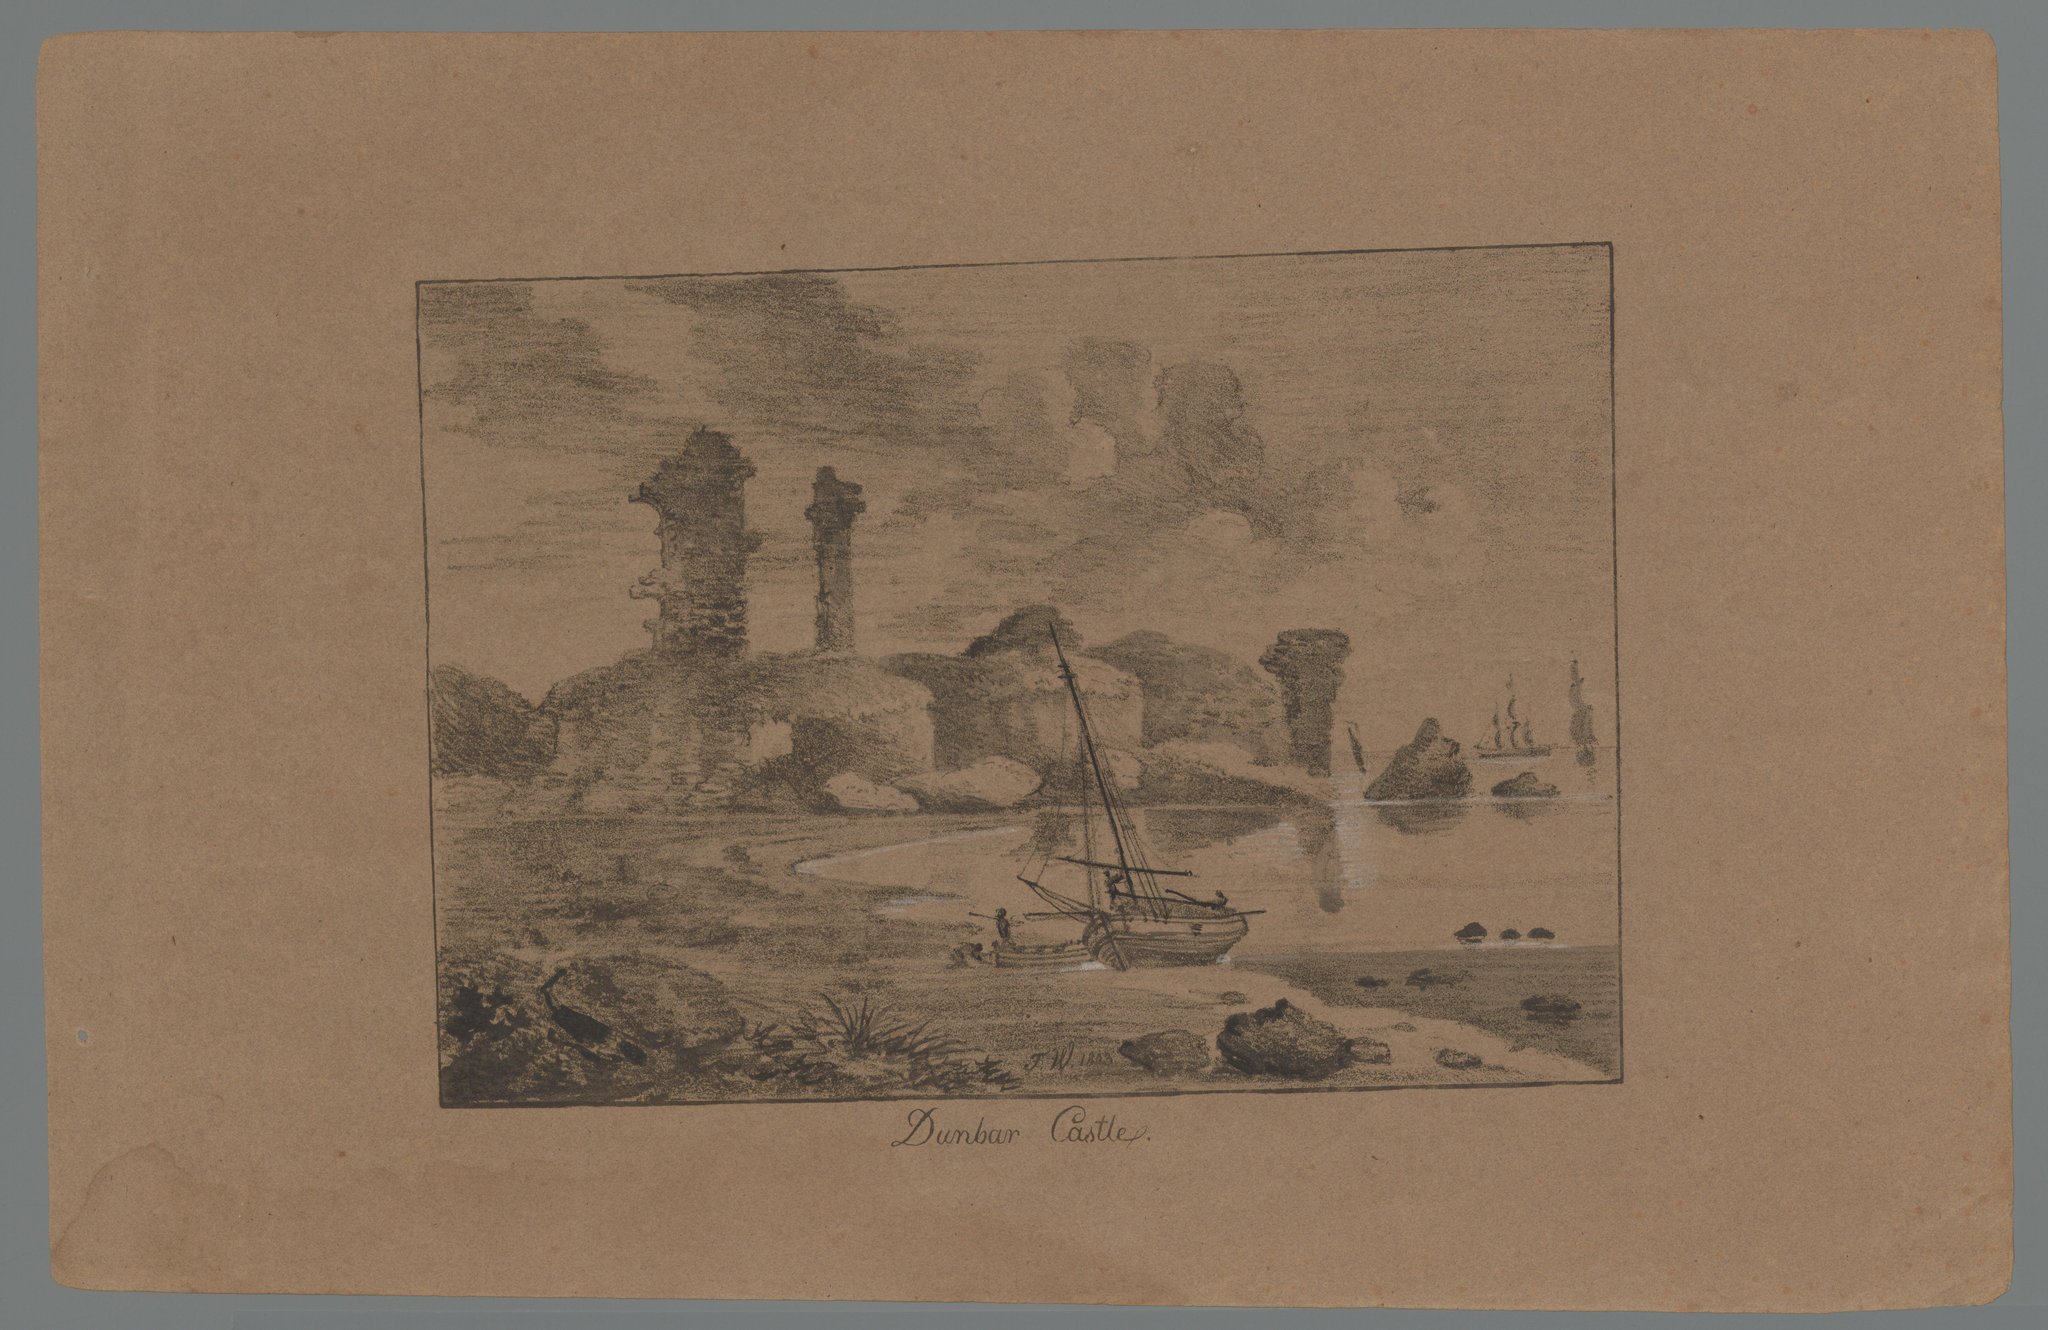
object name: print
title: Gezicht op Dubar Castle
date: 1803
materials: chalk, ink, paper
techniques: brush, lithograph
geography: london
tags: landscape with ruins, water course (+ landscape with figures, staffage), ruin of a dwelling, house, castle, etc.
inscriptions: collector's mark: Lugt 2233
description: Deze prent behoort tot de serie 'Twelve views in Scotland, delineated by a lady in the polyautographic art of drawing on stone'. Deze serie met twaalf lithografieën is een van de vroegste reeksen lithografieën in Groot-Brittannië.